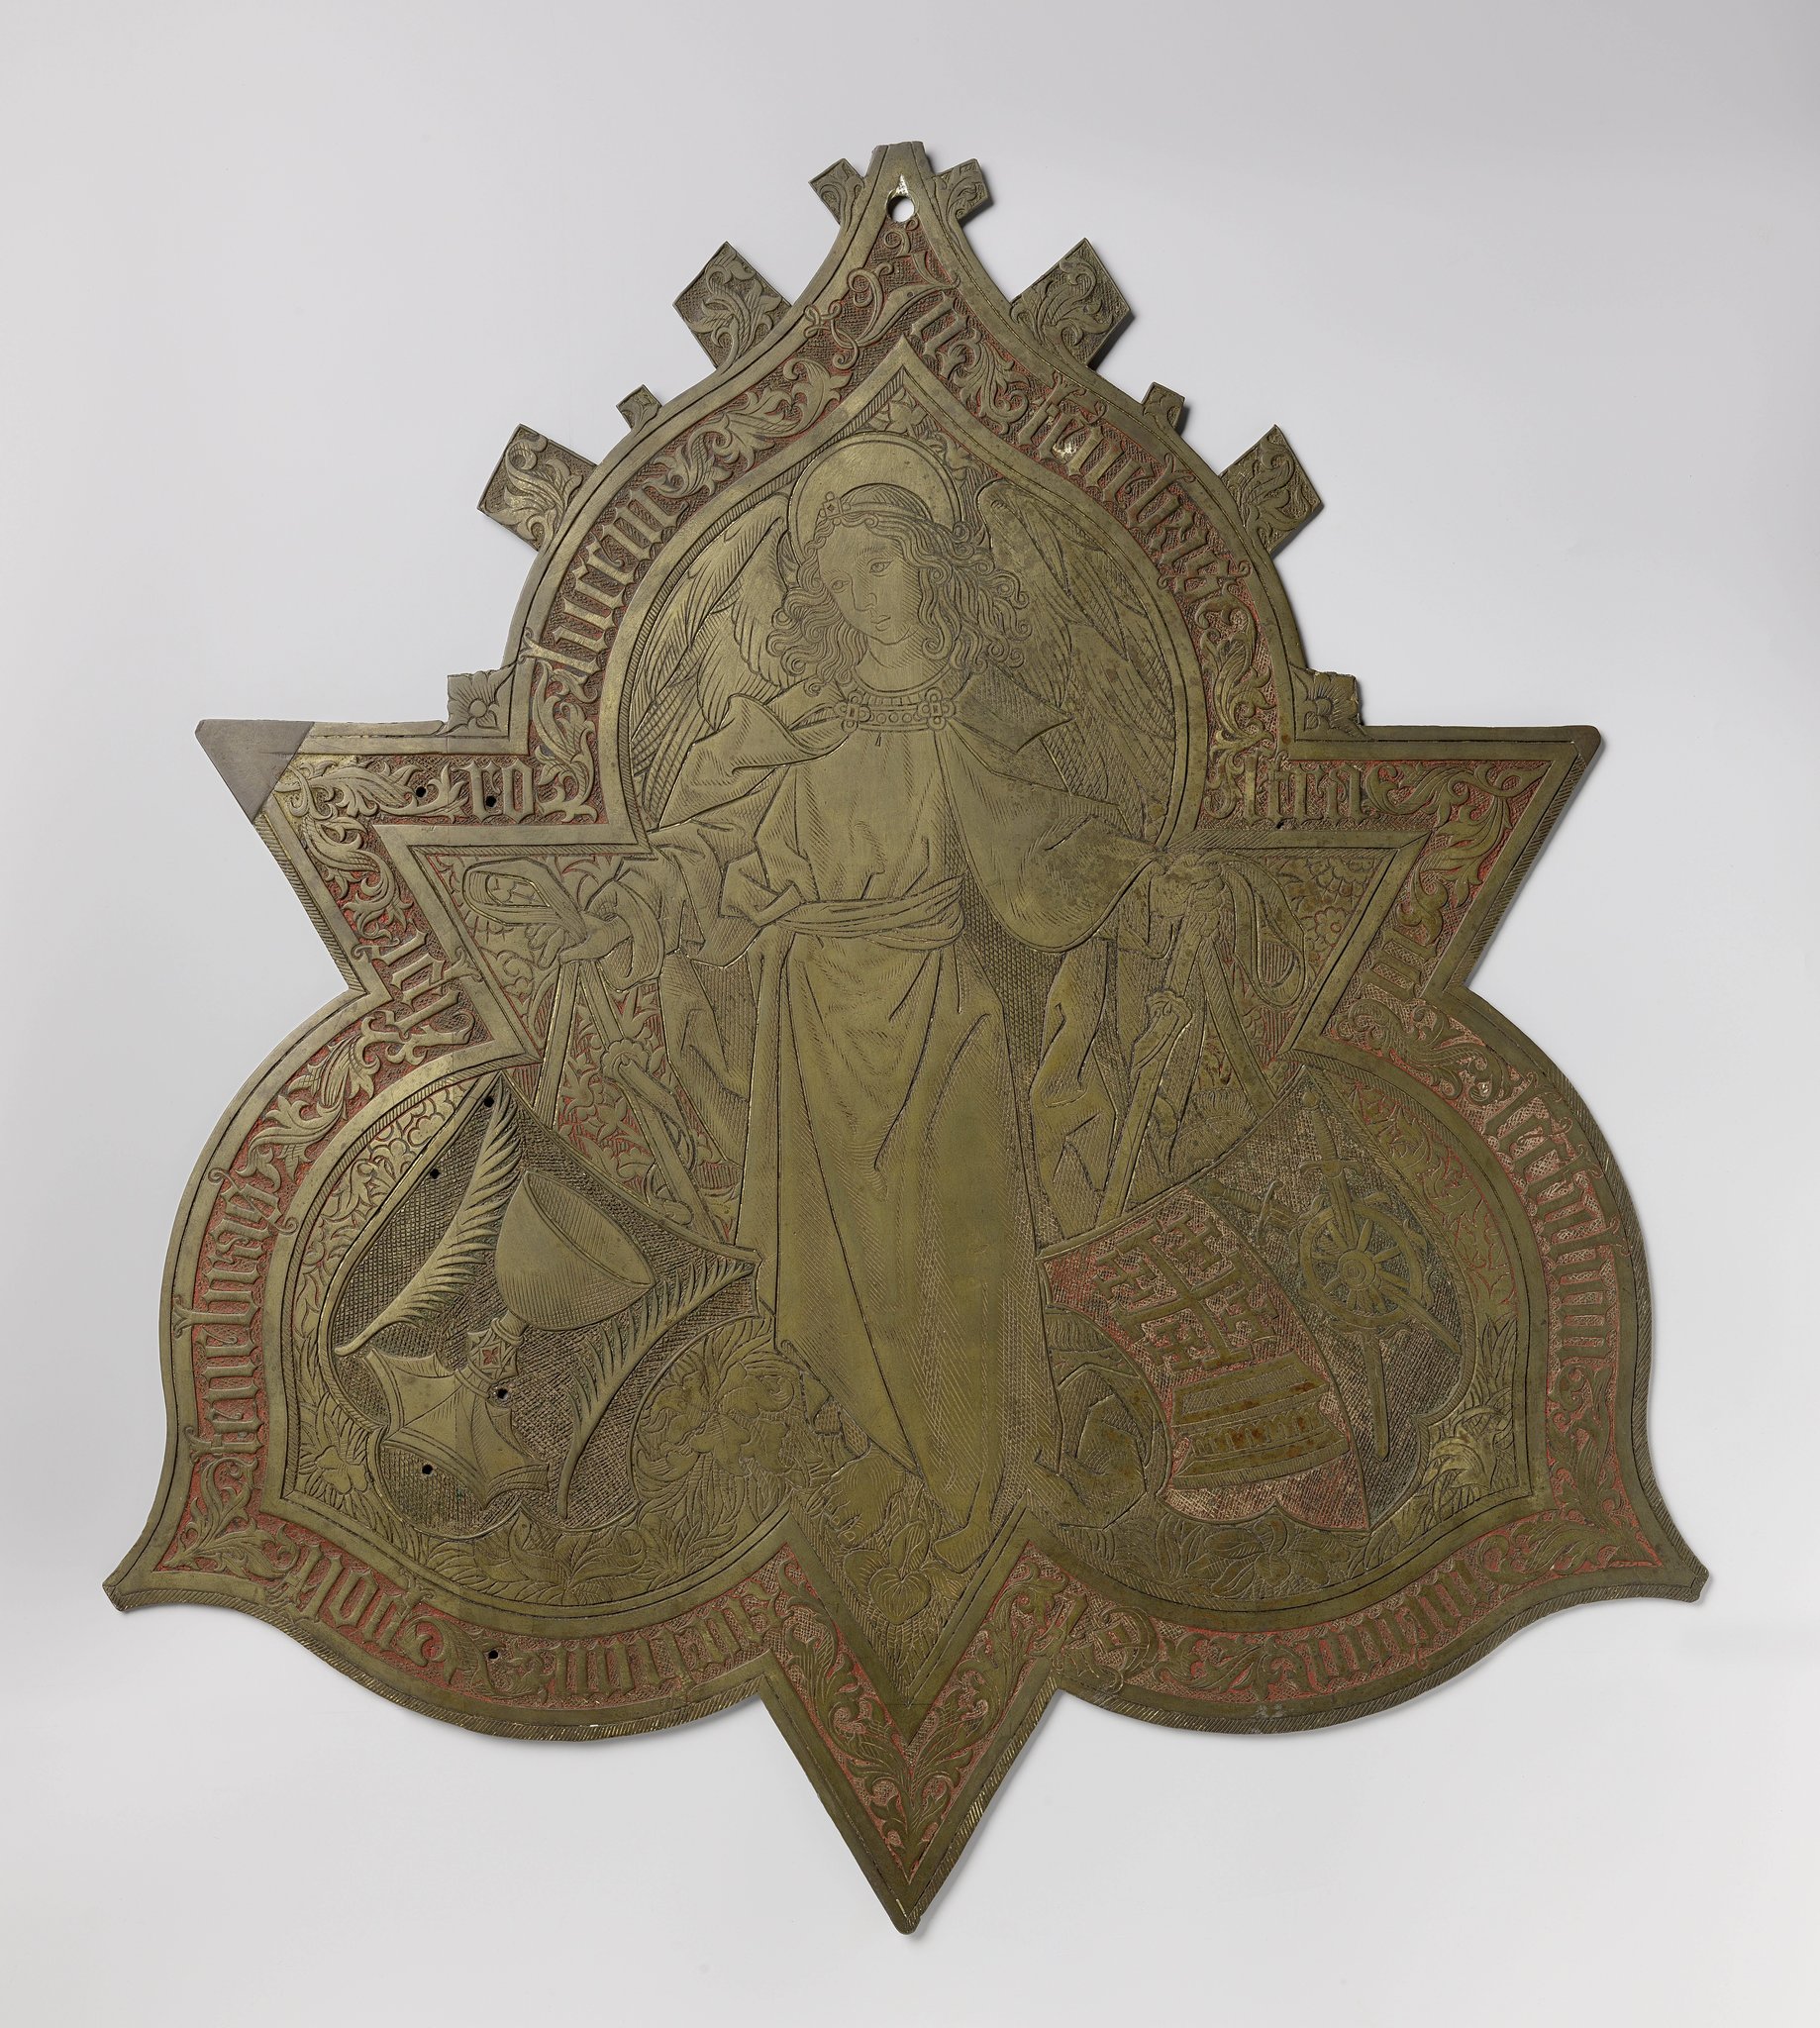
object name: plate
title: Central Plate of the Tombstone of Gijsbert Willemsz Raet, with an Angel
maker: Anonymous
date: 1511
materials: brass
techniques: casting, cutting, engraving, gilding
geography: low countries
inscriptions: inscription, along the border, incised: ‘In tenebris stra vi lectulum meum Et rursum post tenebras spe ro lucem’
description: Together with the four corner plates in the display case, this one decorated the hardstone tombstone of Vicar Gijsbert Willemsz Raet (?-1511), in the Jerusalem Chapel at Gouda, which he founded. The skilfully engraved representations were initially partially coloured in. Although the engraving technique used here differs from that used on plates for prints, the affinity is clear.